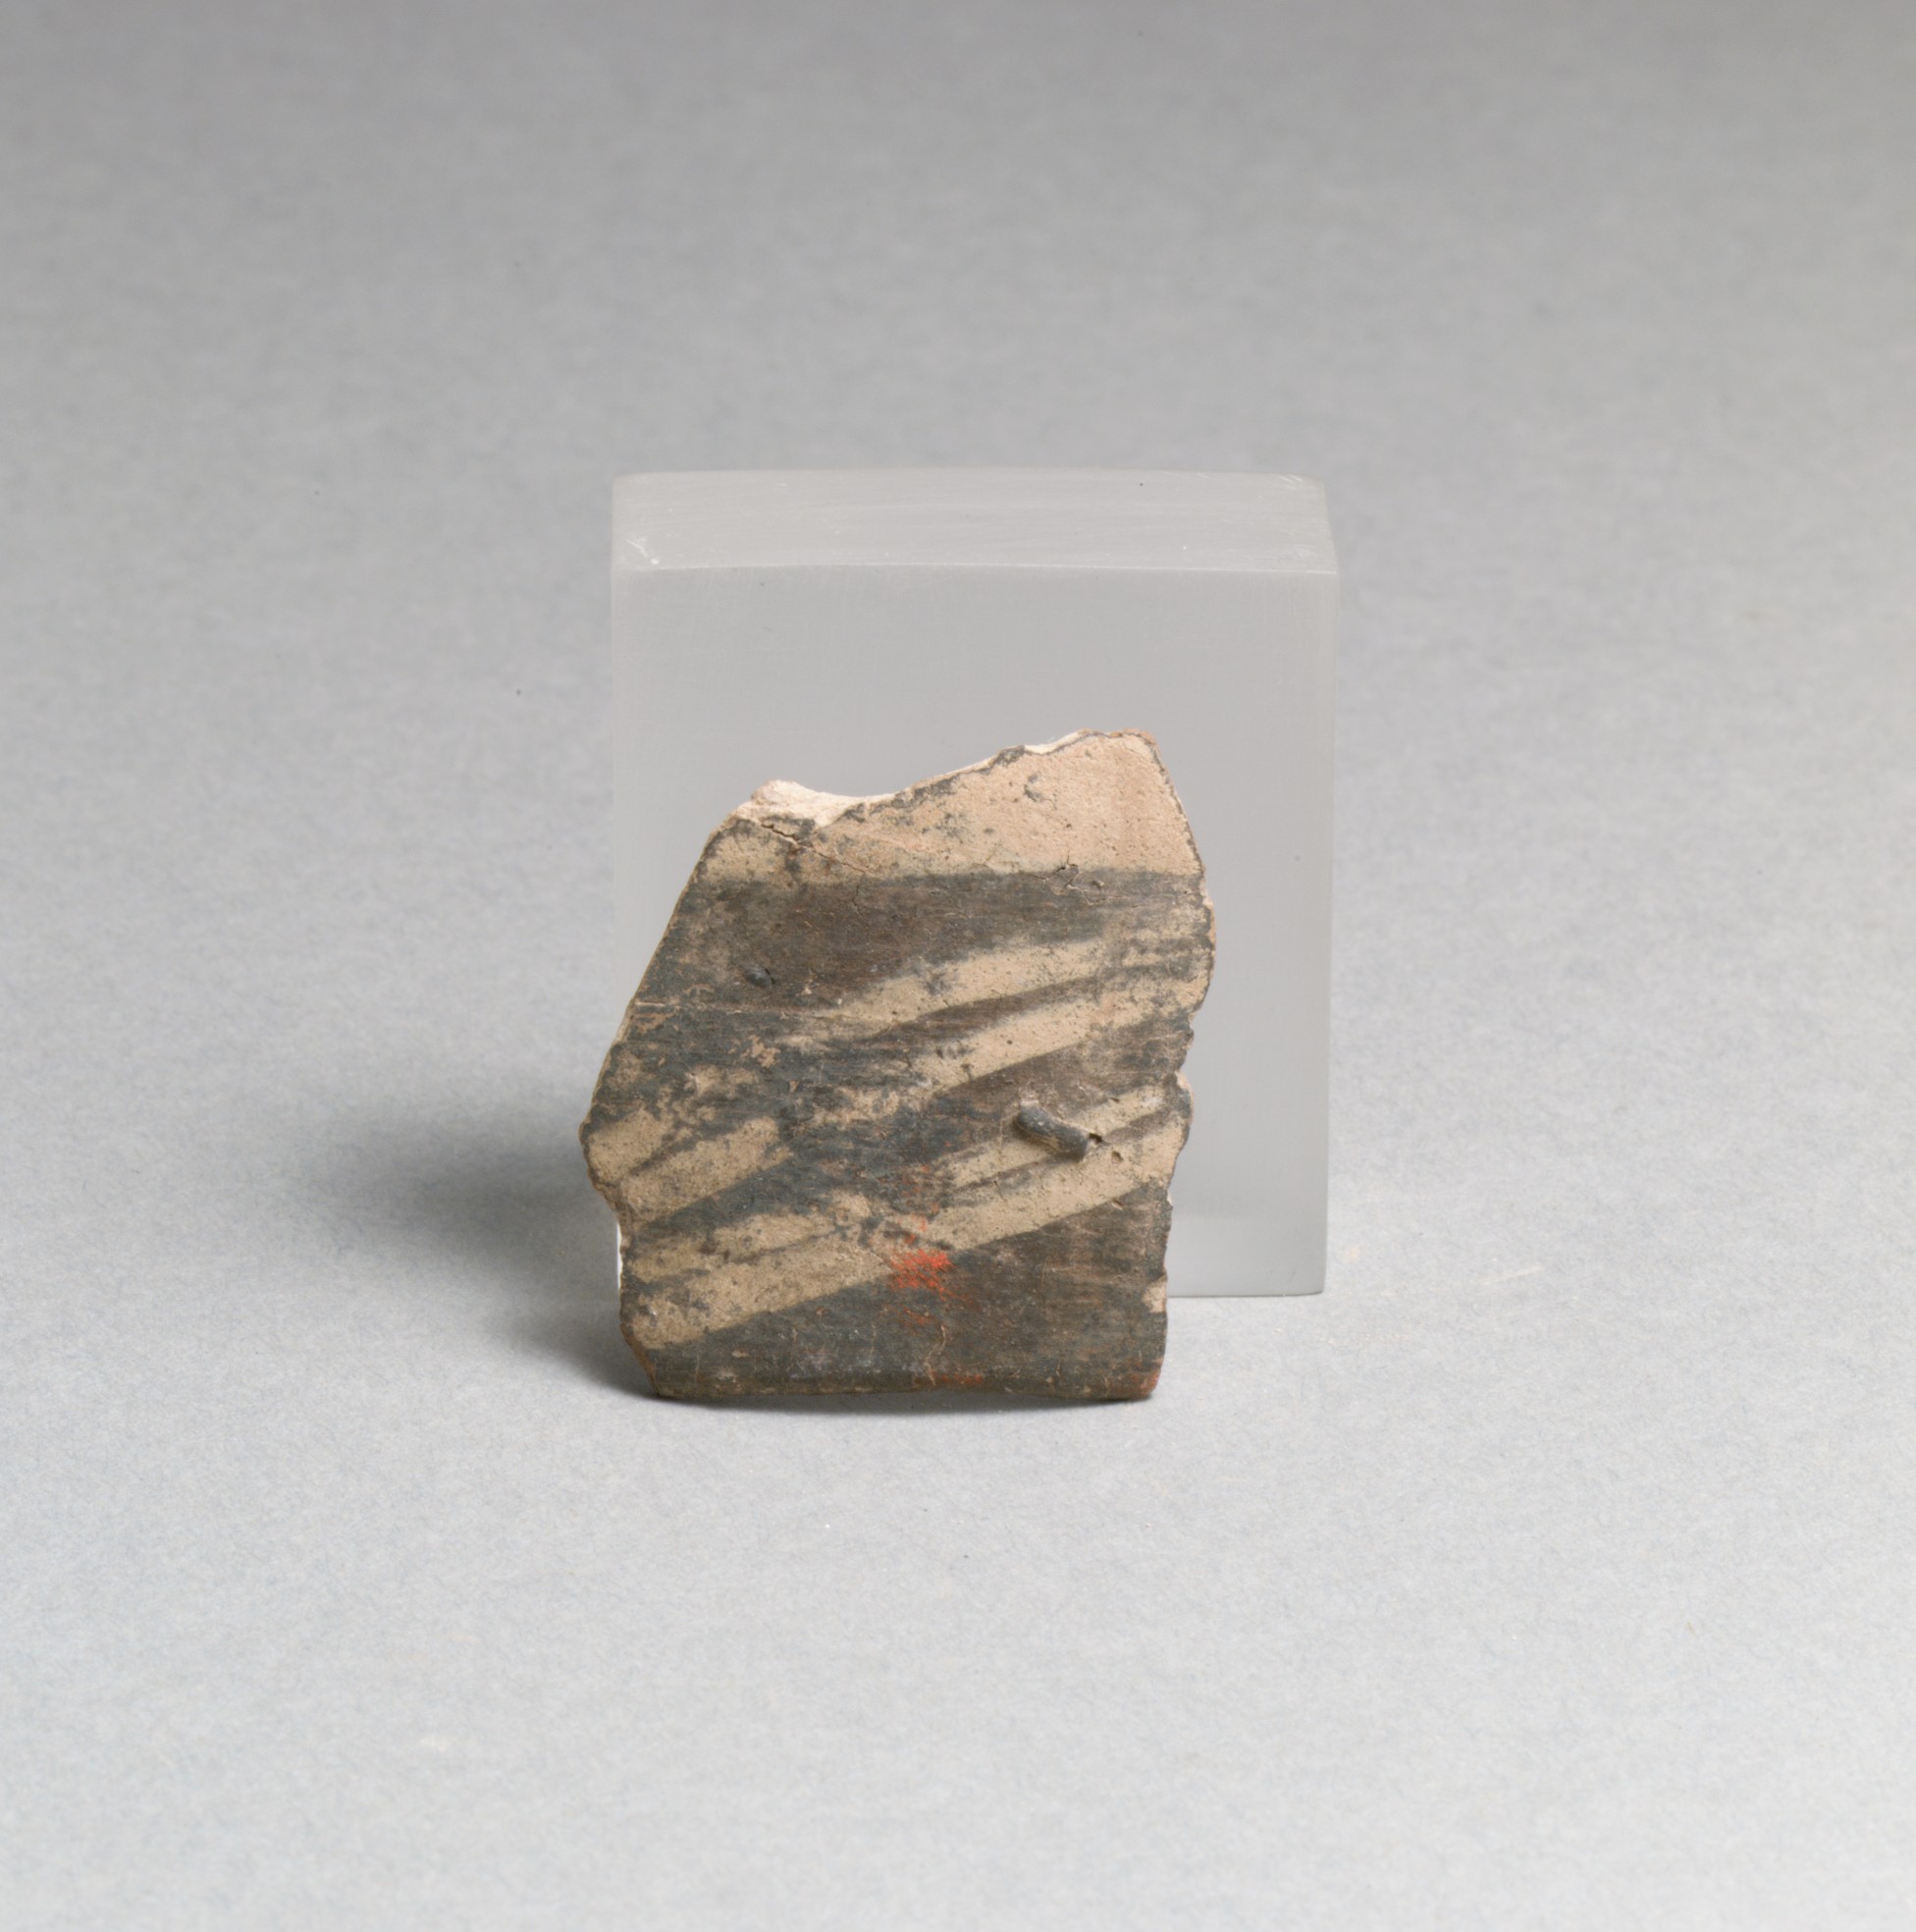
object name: vase fragment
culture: minoan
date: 2600-2000 BCE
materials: terracotta